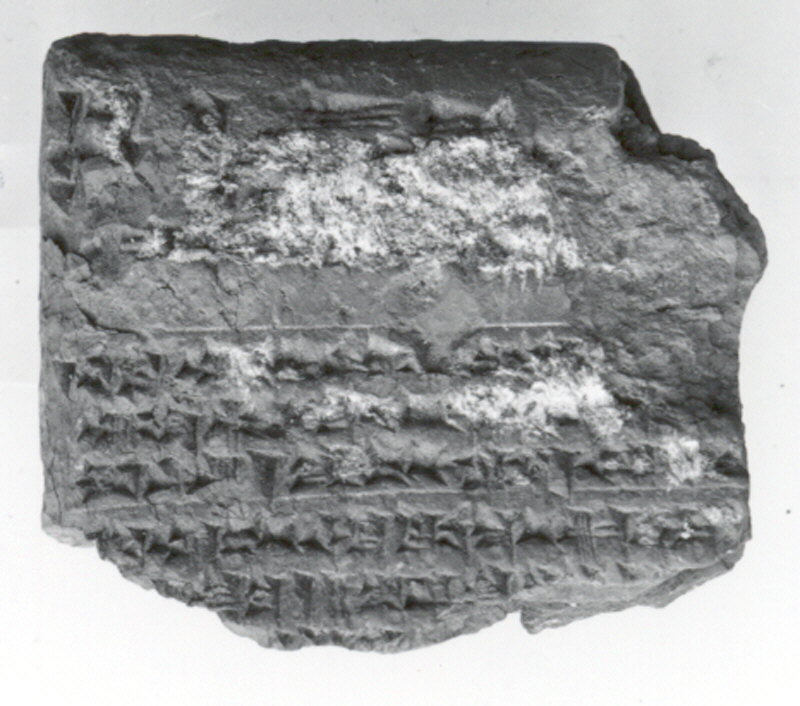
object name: cuneiform tablet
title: Cuneiform tablet: Shumma alu, tablet 17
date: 333-1 BCE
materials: clay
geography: mesopotamia